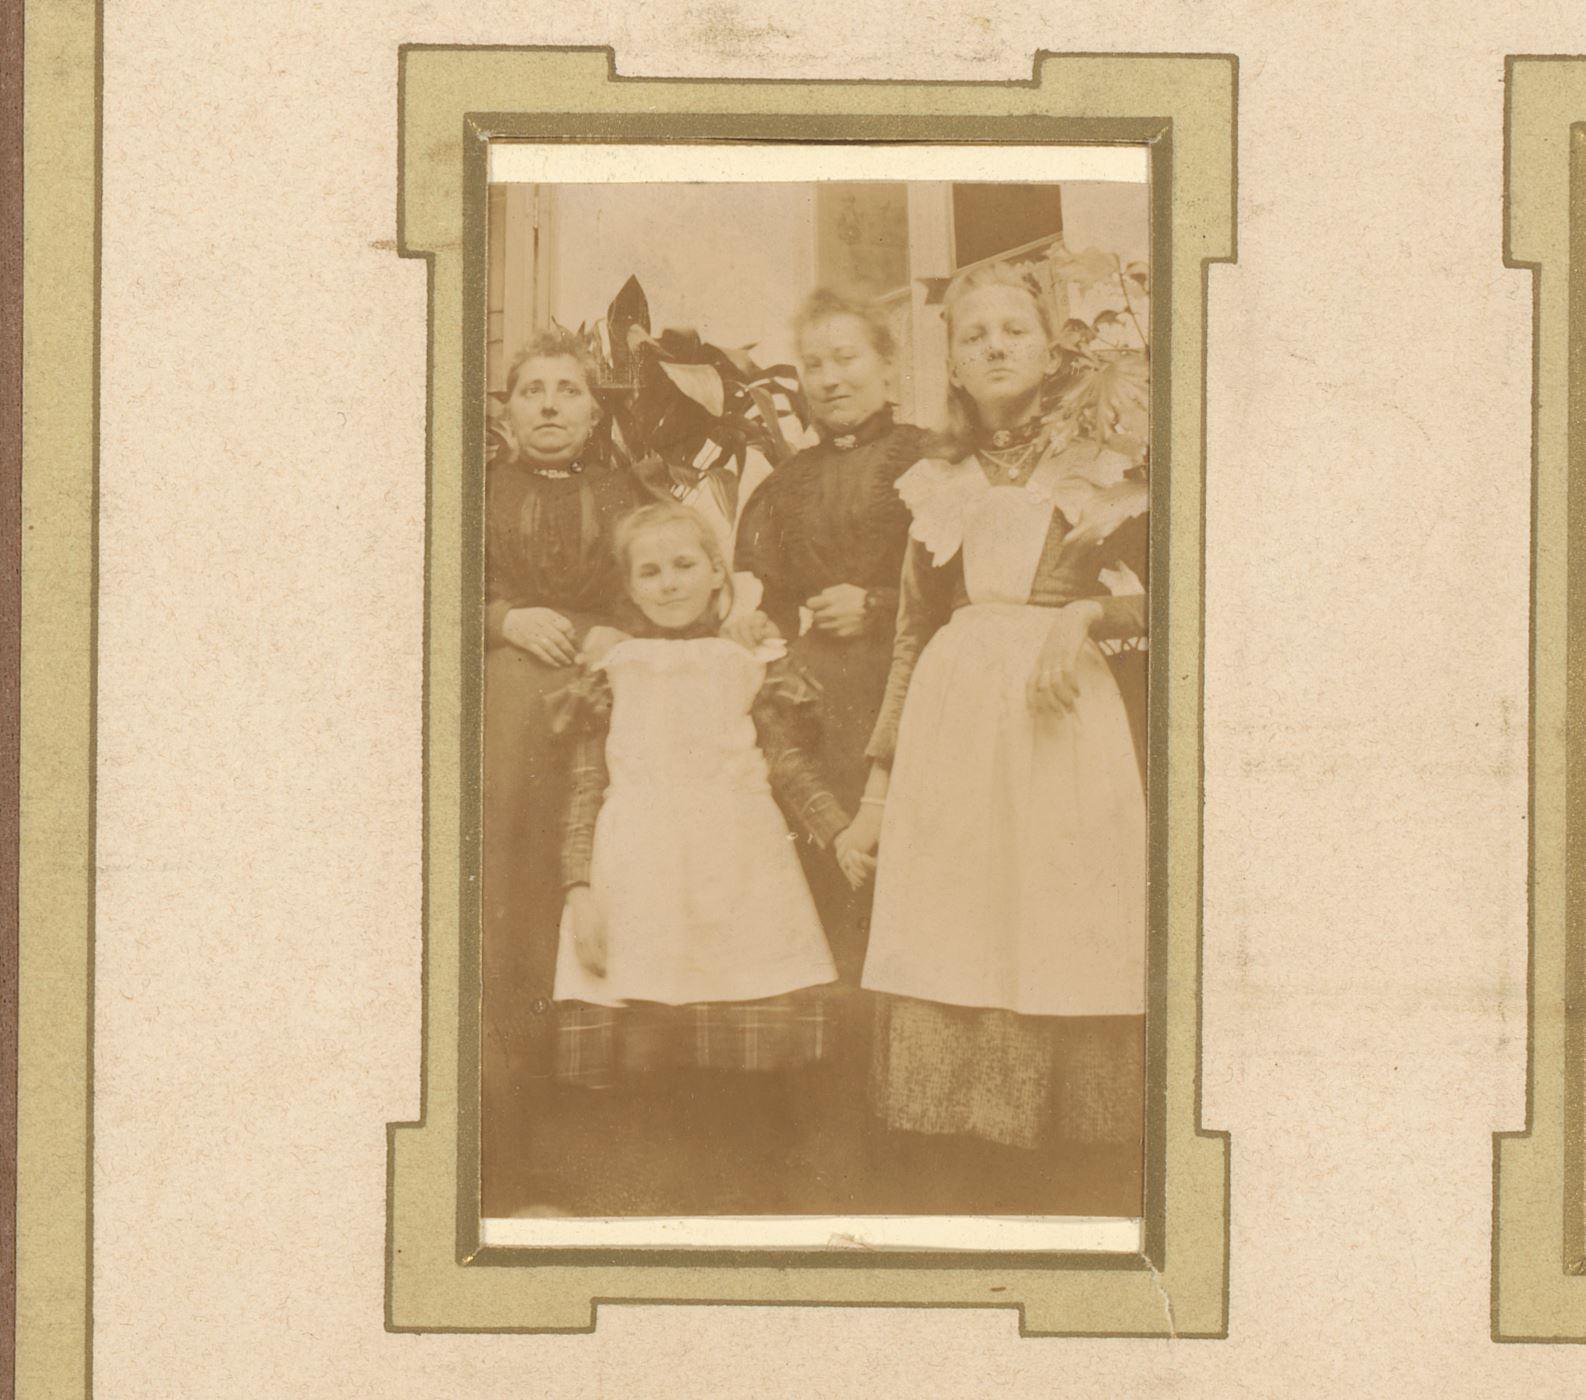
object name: album leaf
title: Groepsportret van vier vrouwen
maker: Anonymous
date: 1860-1900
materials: cardboard, photographic support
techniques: albumen print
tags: anonymous historical persons portrayed in a group, in a group-portrait